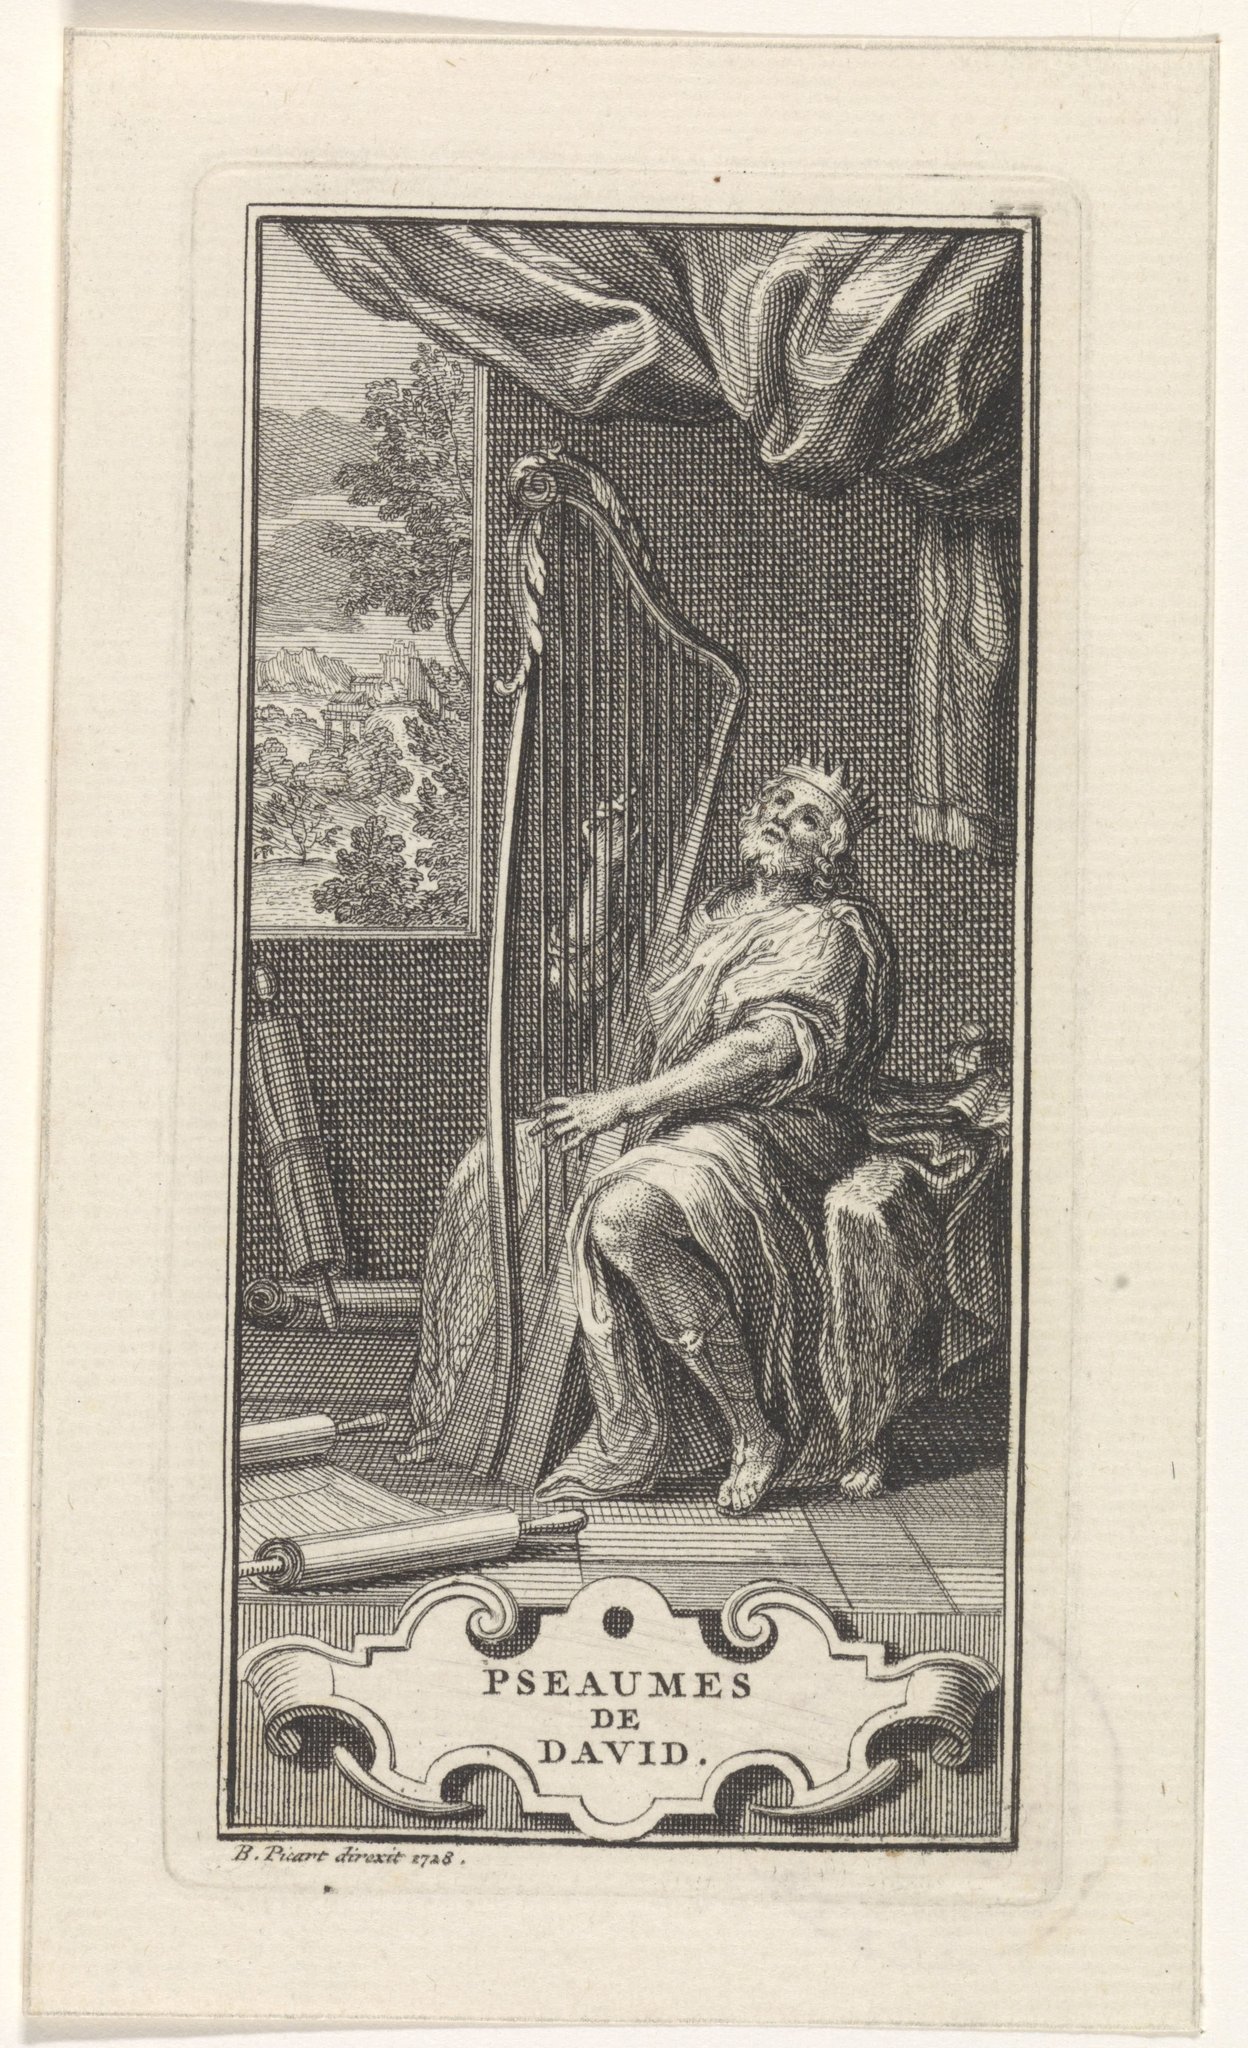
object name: titelblad, titelpagina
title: David bespeelt zijn harp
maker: bernard picart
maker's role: draughtsman, print maker, publisher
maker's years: 1673-1733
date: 1728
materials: paper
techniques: engraving, etching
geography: amsterdam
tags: david as musician, usually playing the harp, landscape with ruins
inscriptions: collector's mark: Lugt 240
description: Koning David speelt op zijn harp in een kamer. Door het venster een gezicht op een landschap met ruïnes. Onder de voorstelling een cartouche met de titel in het Frans.